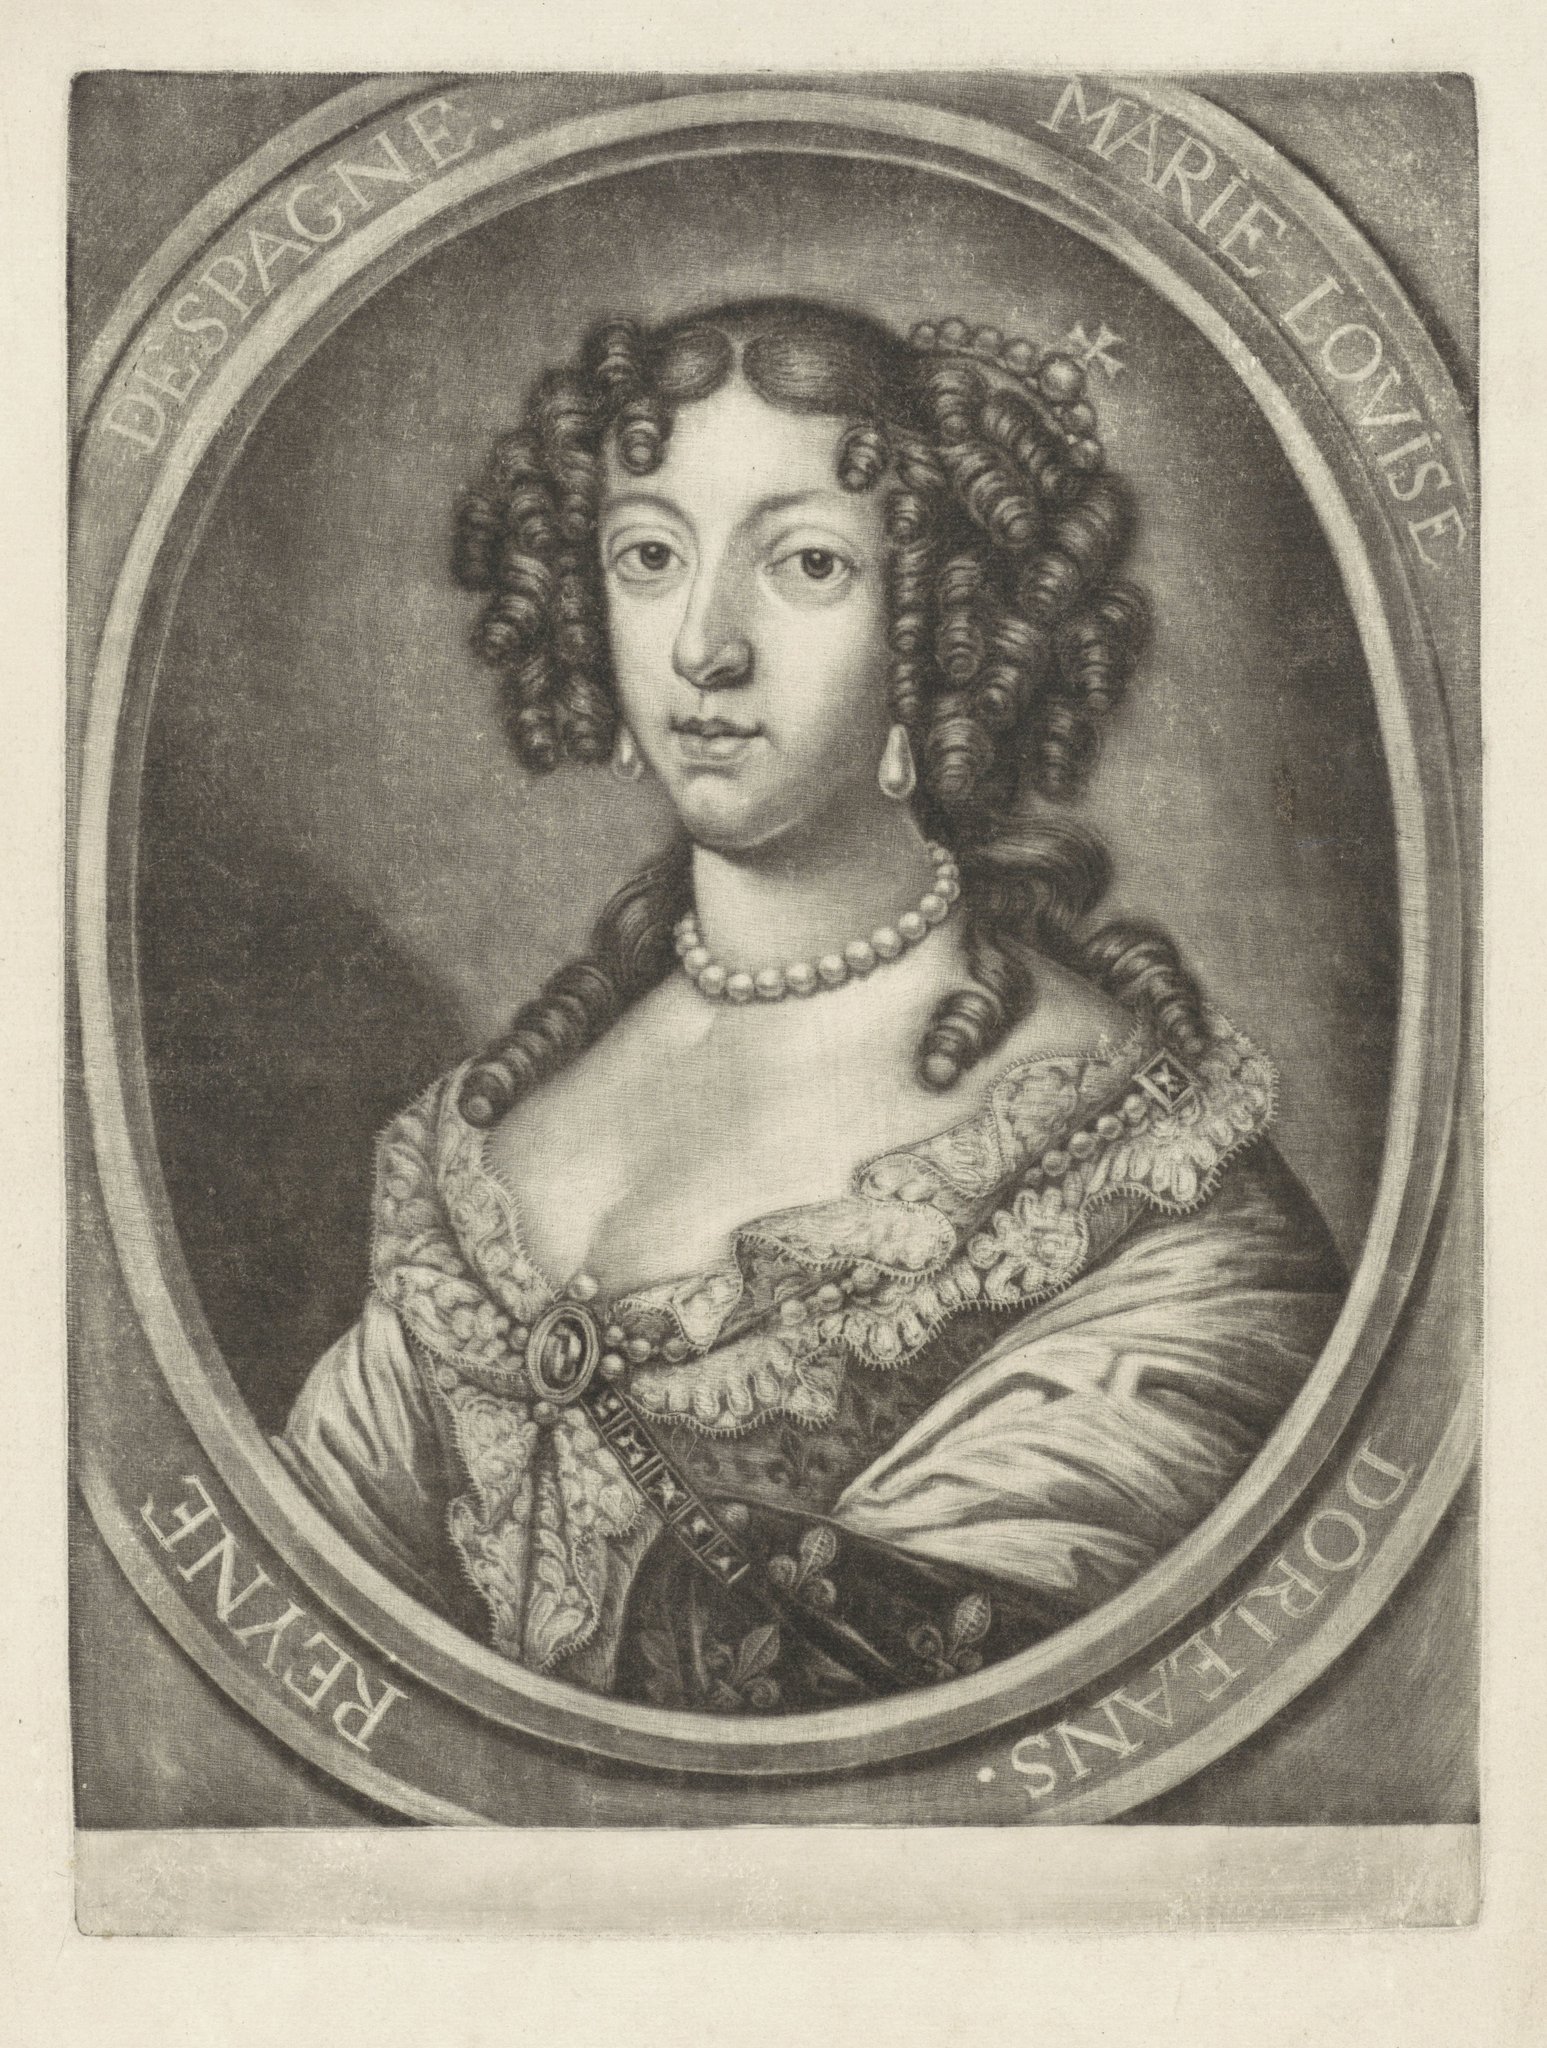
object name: print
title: Portret van Marie Louise van Orléans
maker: jan van somer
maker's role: draughtsman, print maker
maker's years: 1645-1699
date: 1655-1700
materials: paper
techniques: mezzotint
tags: pearl; pearl necklace (+ women's clothes)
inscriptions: collector's mark: Lugt 2228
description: Marie Louise van Orléans, koningin van Spanje dankzij haar huwelijk met koning Karel II van Spanje. Ze draagt parels om haar hals en ik haar oren.